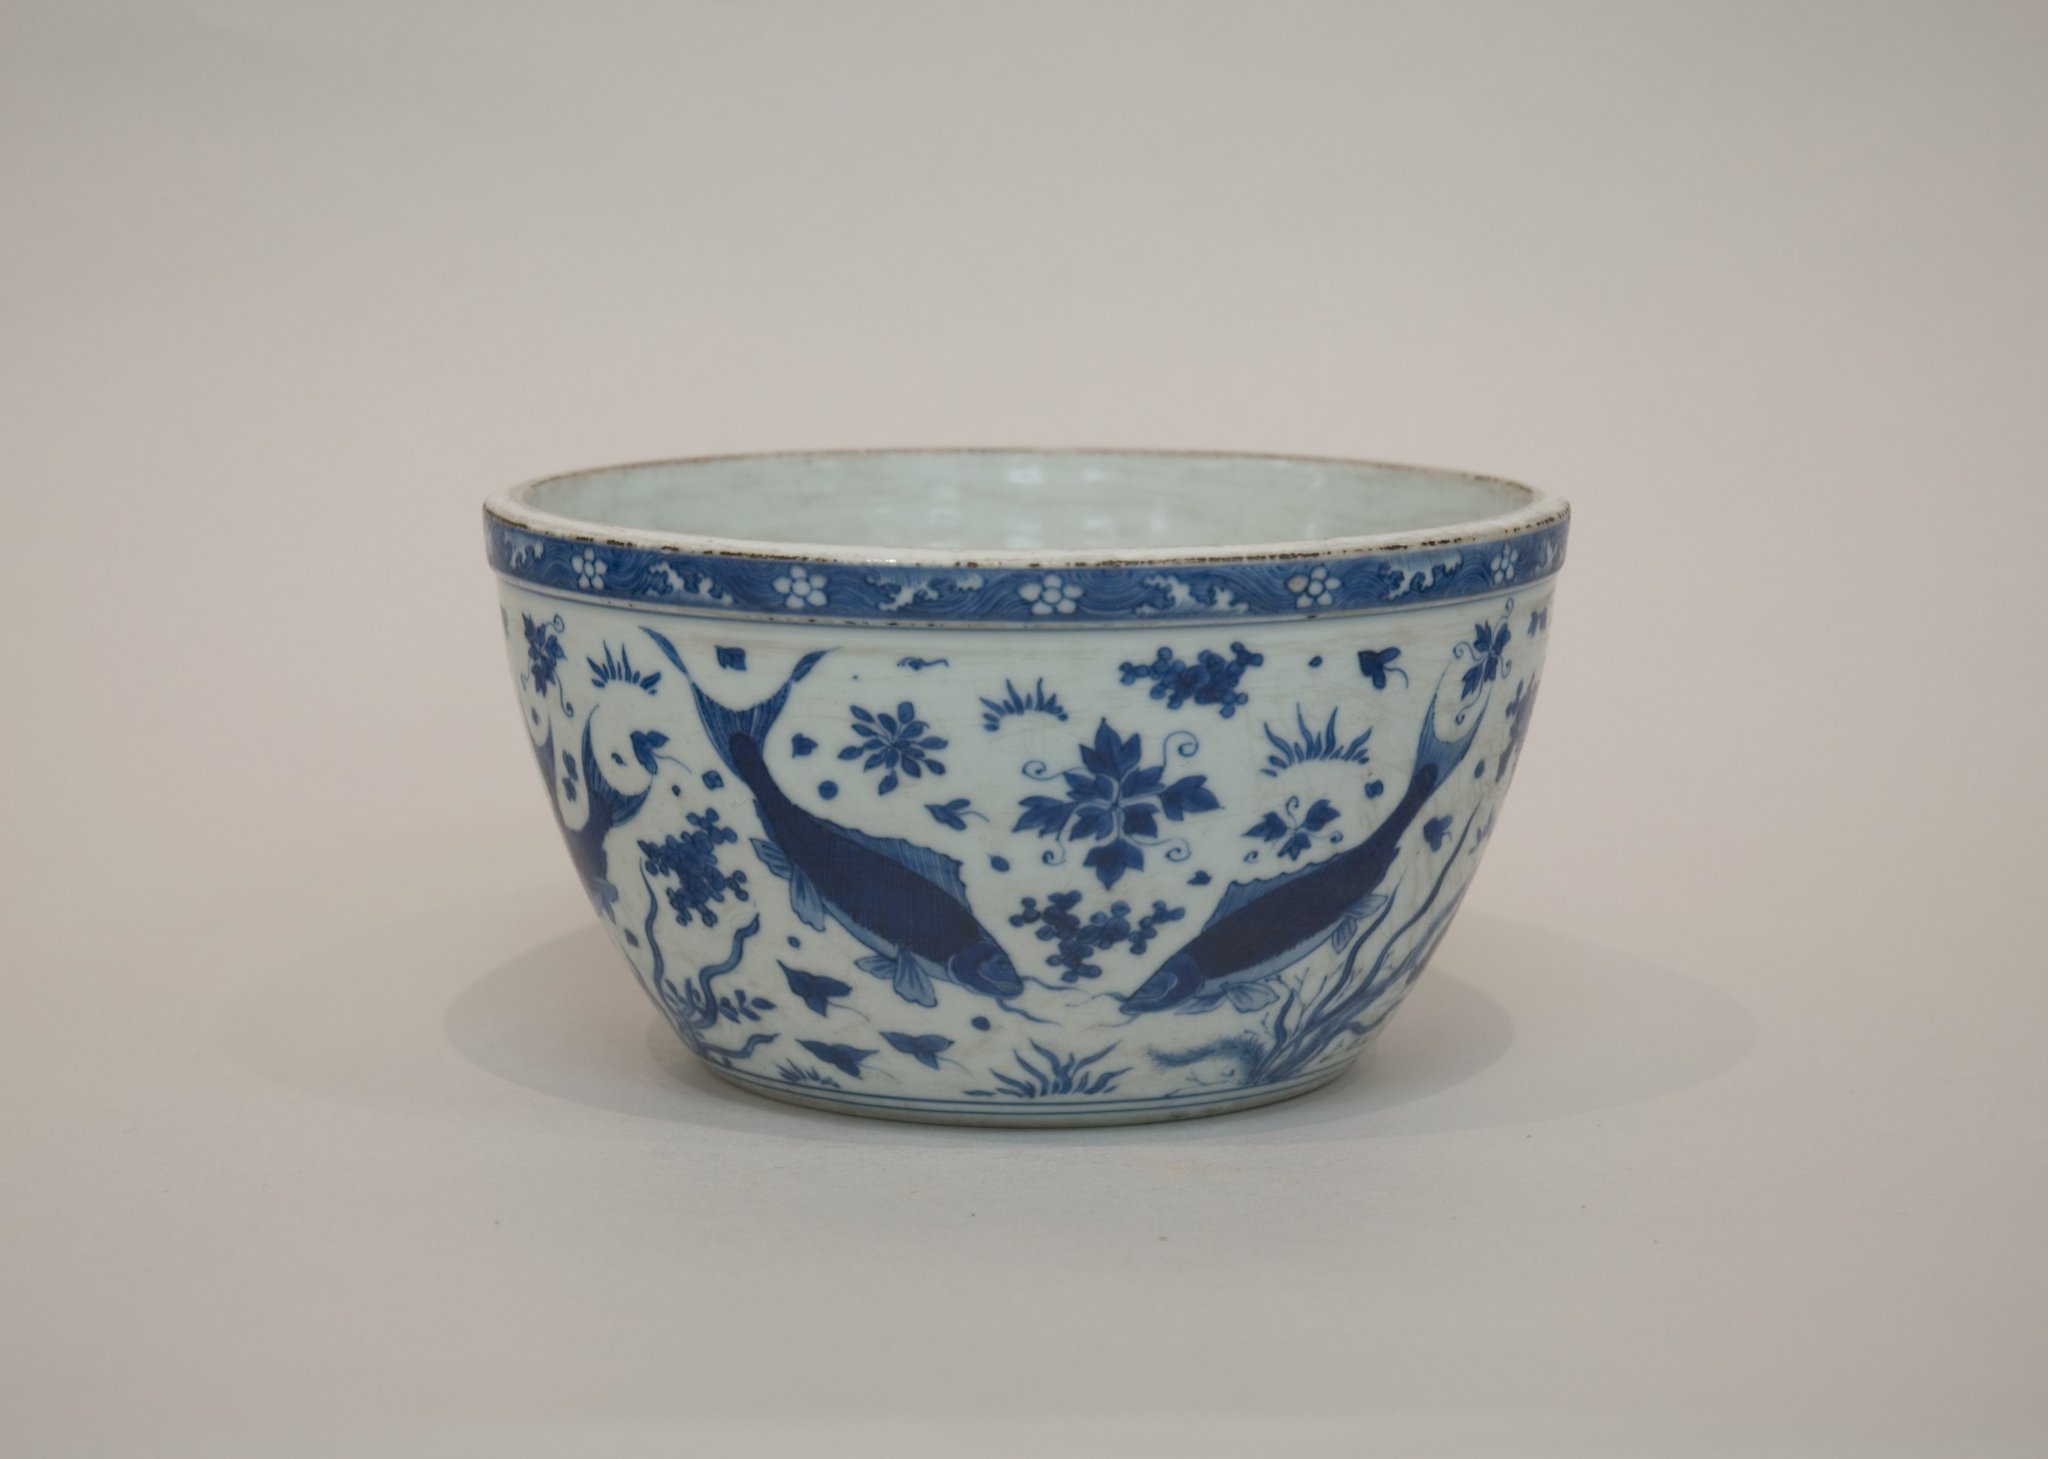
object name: bowl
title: Bowl with fish in pond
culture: chinese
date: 1501-1600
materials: cobalt, glaze, porcelain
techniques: painting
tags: fish